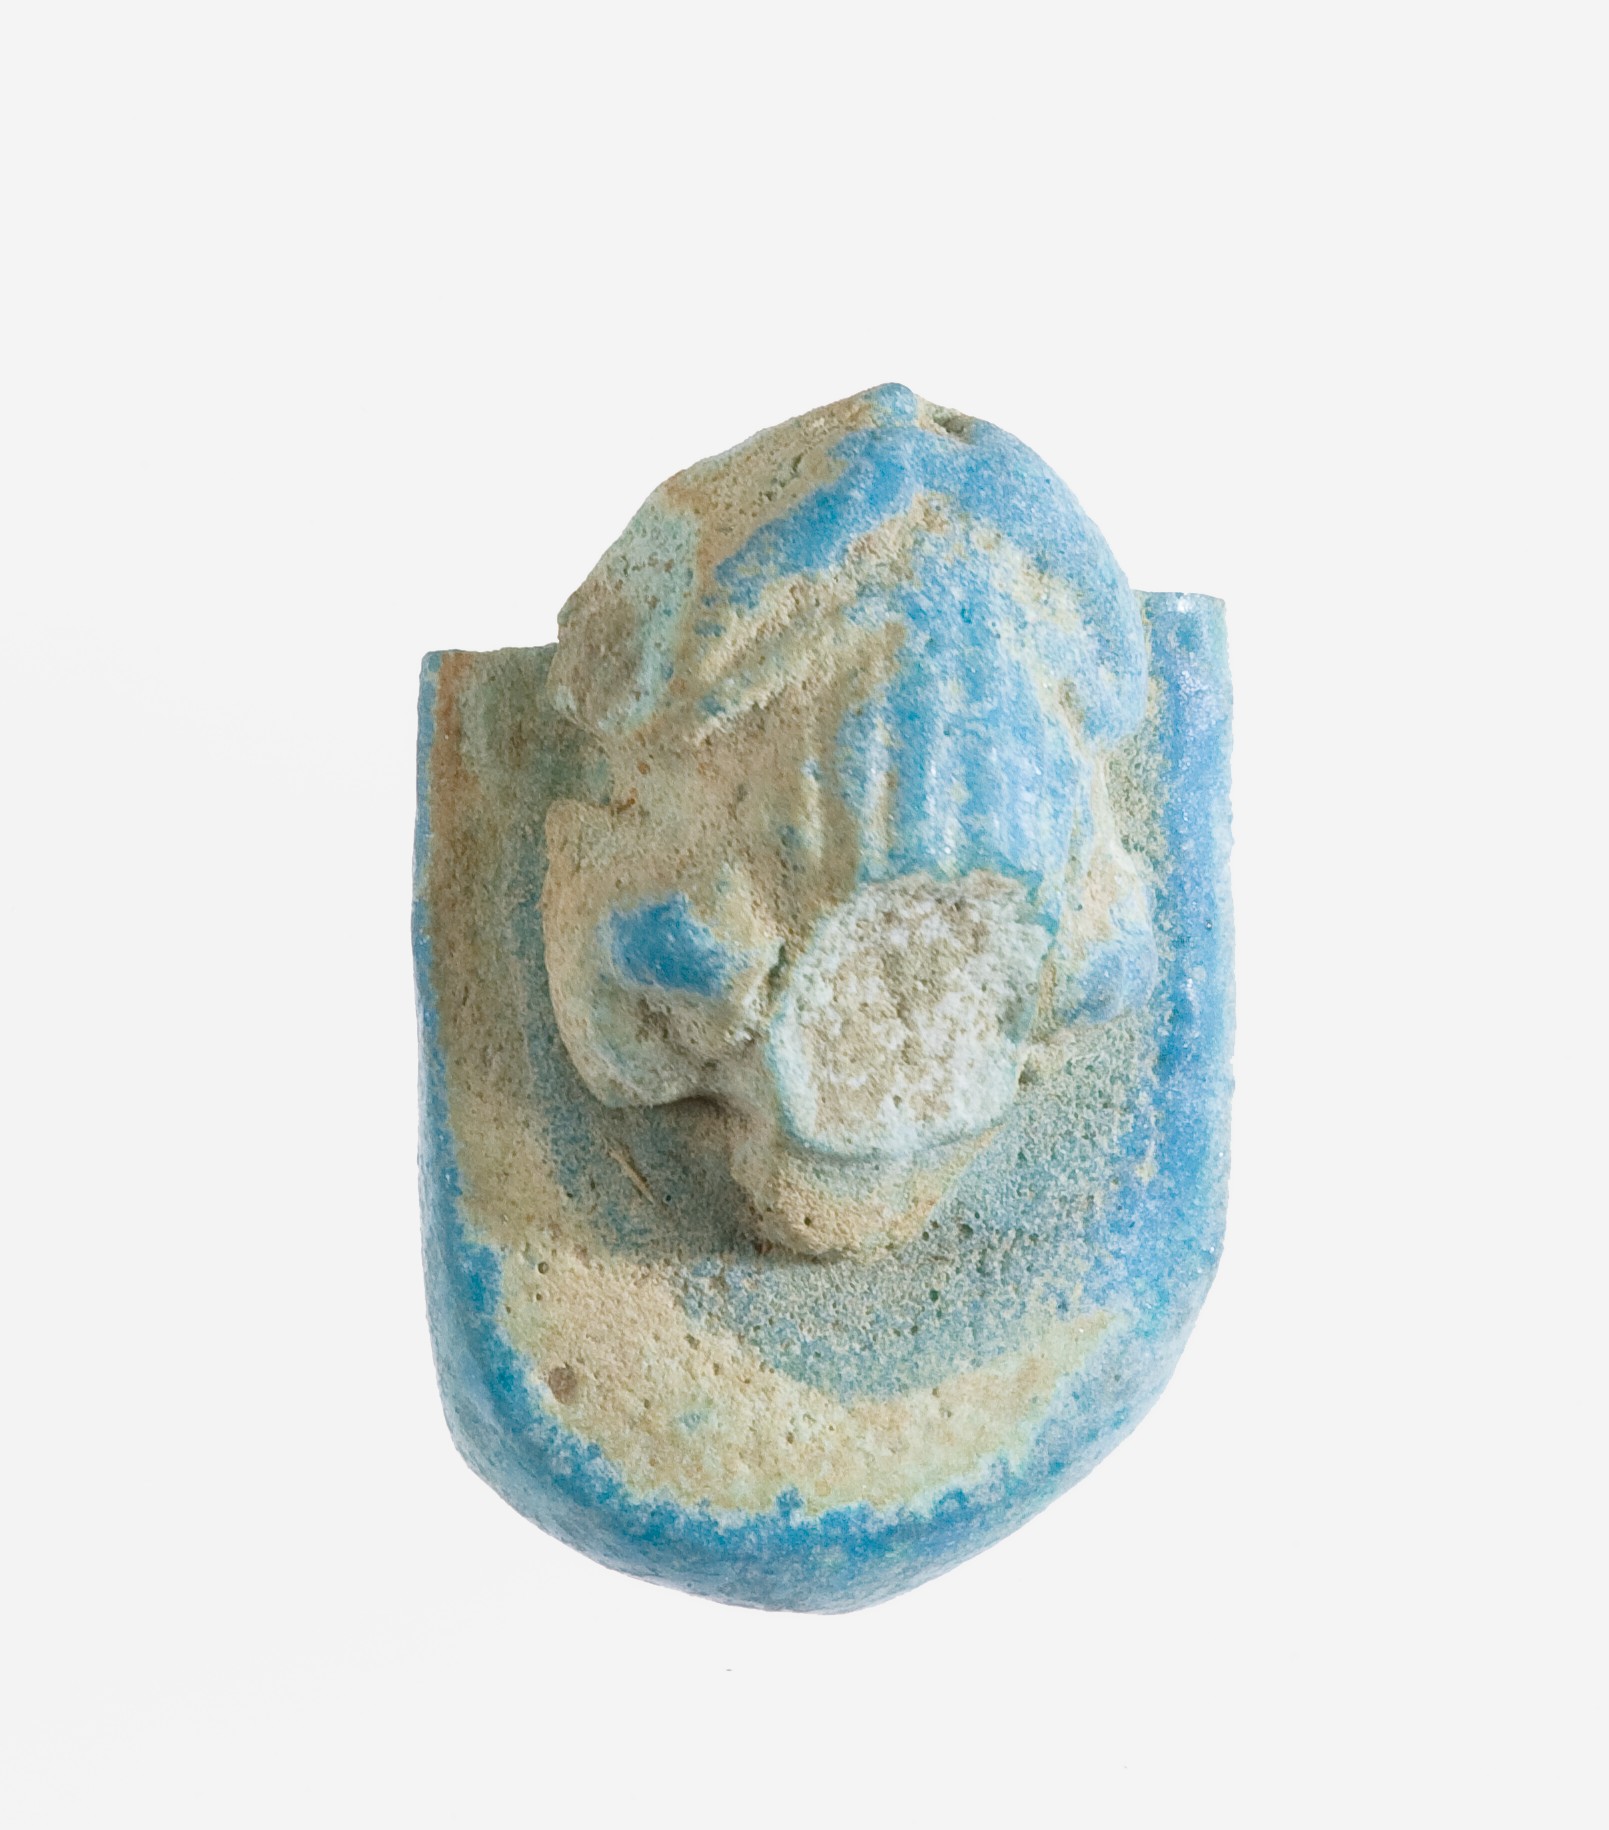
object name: ring fragment, frog in the round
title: Frog Ring Fragment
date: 1390-1352 BCE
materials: faience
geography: egypt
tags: frogs